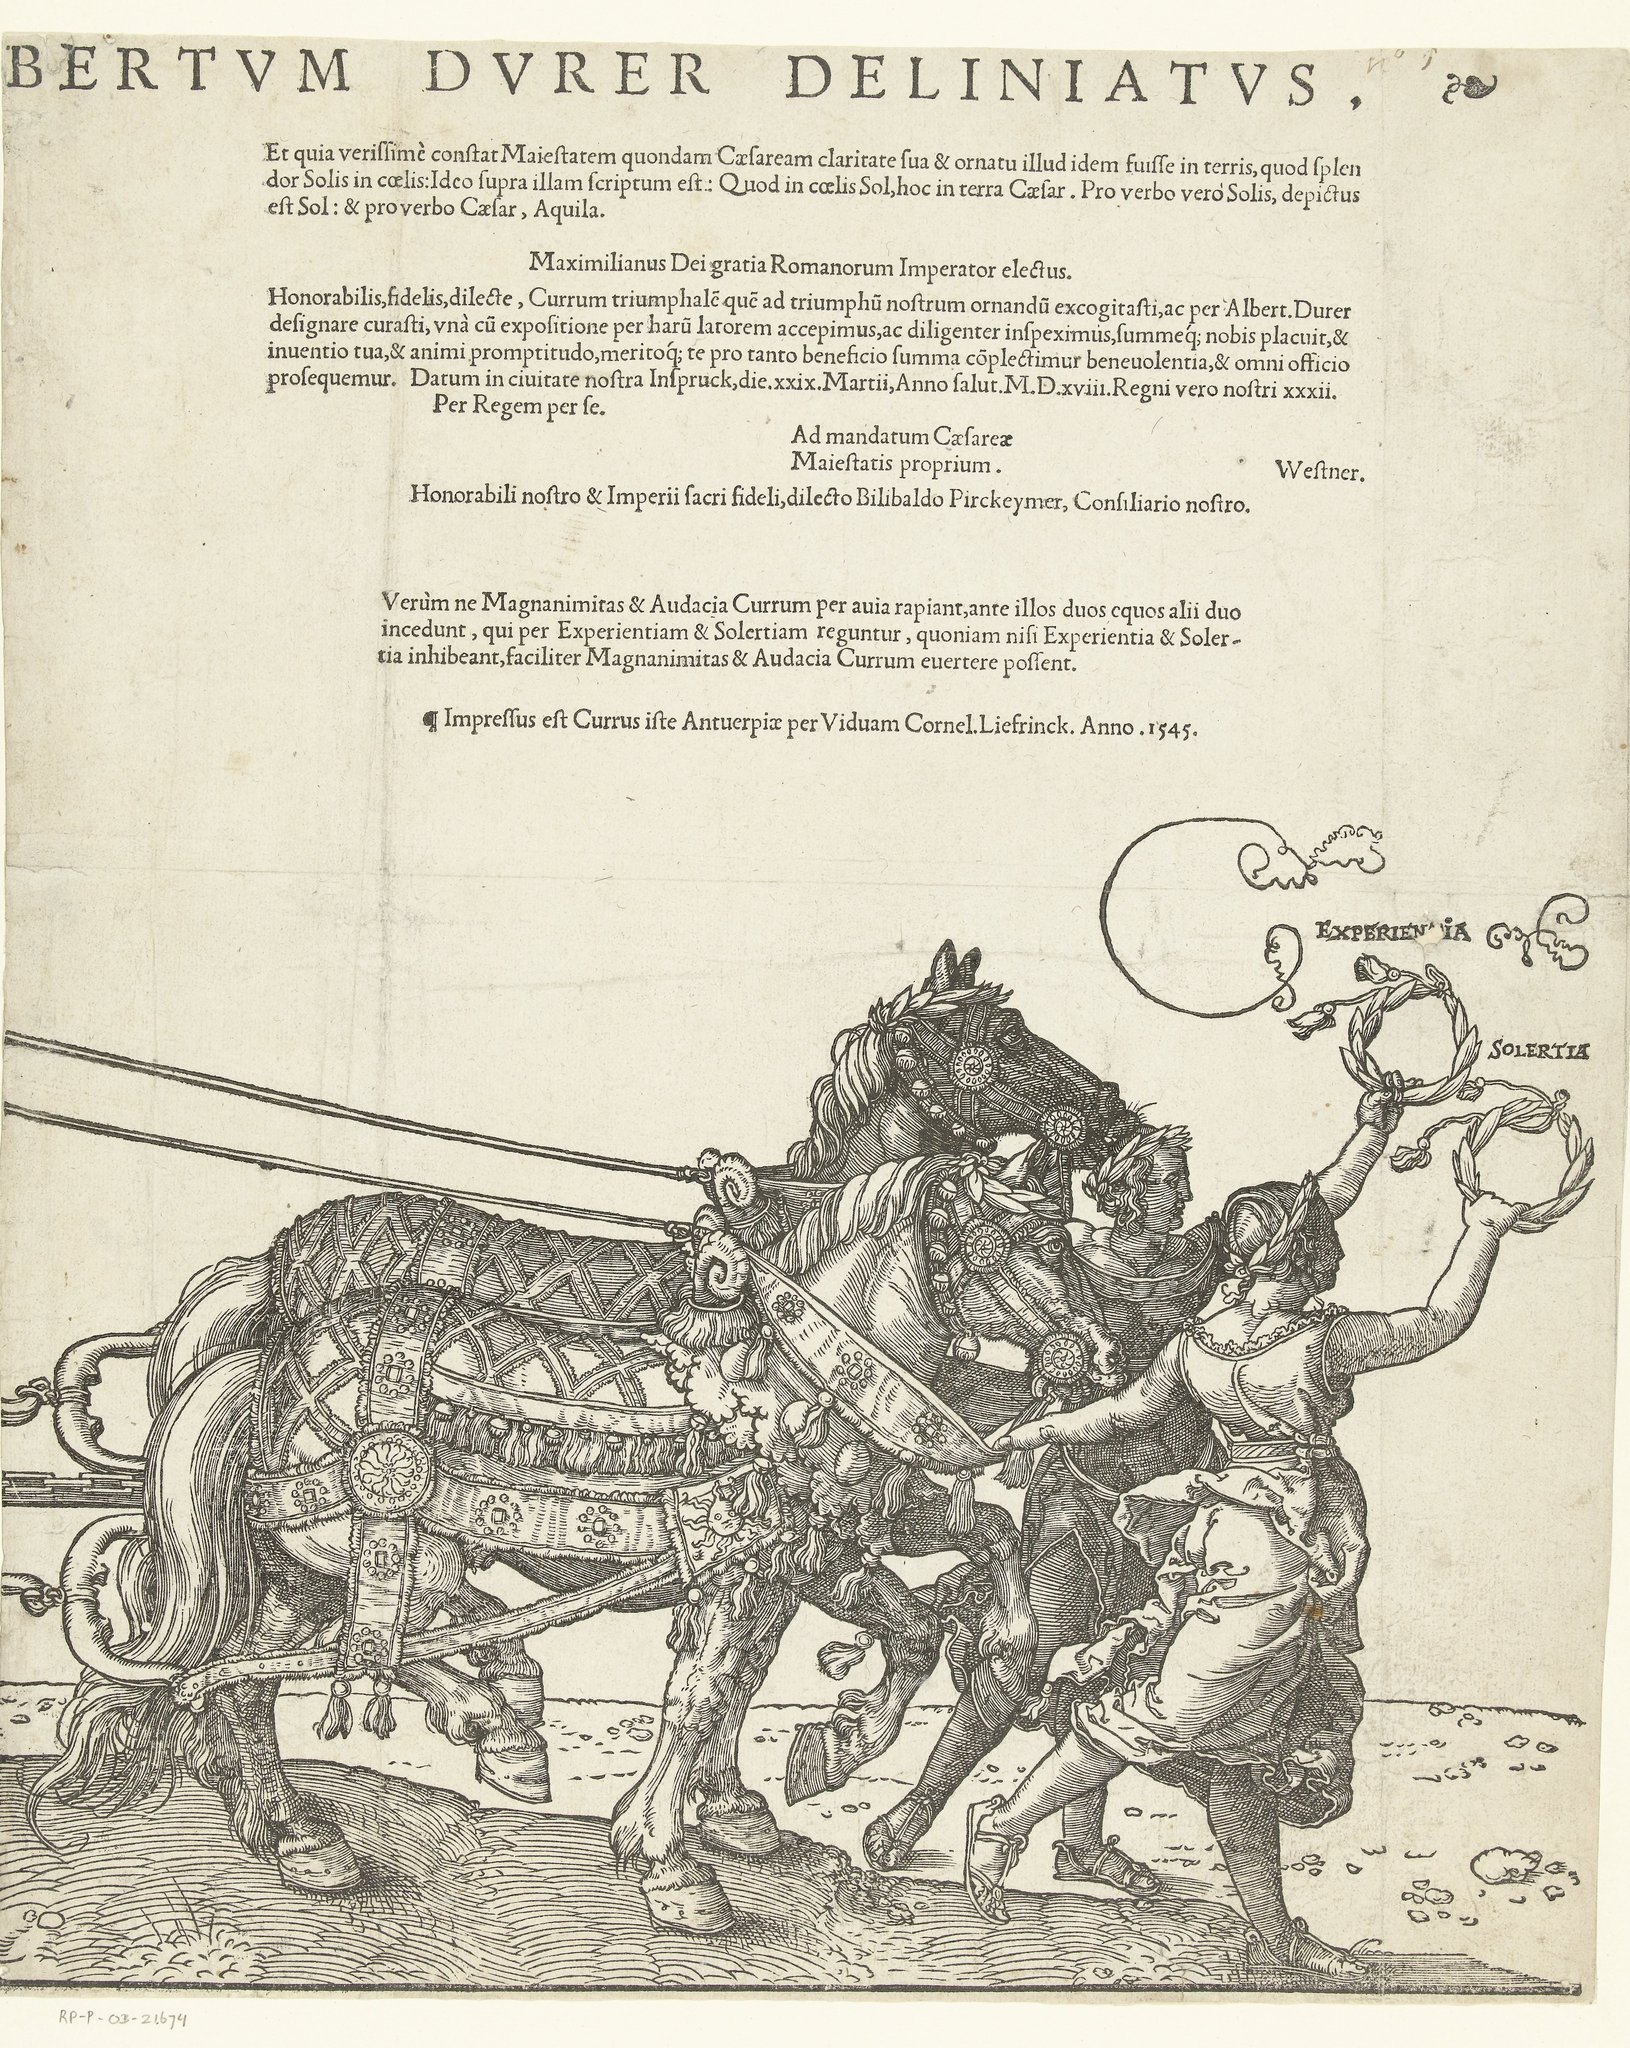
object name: print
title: Kopieën naar Dürers Triomfwagen voor keizer Maximiliaan I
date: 1527-1529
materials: paper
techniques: letterpress printing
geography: antwerp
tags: maximilian i (holy roman emperor), chariot, triumphal car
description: De grote triomfwagen ter ere van keizer Maximiliaan I bij zijn overlijden op 12 januari 1519. Achtste blad met het zesde span paarden met Experientia en Solertia.